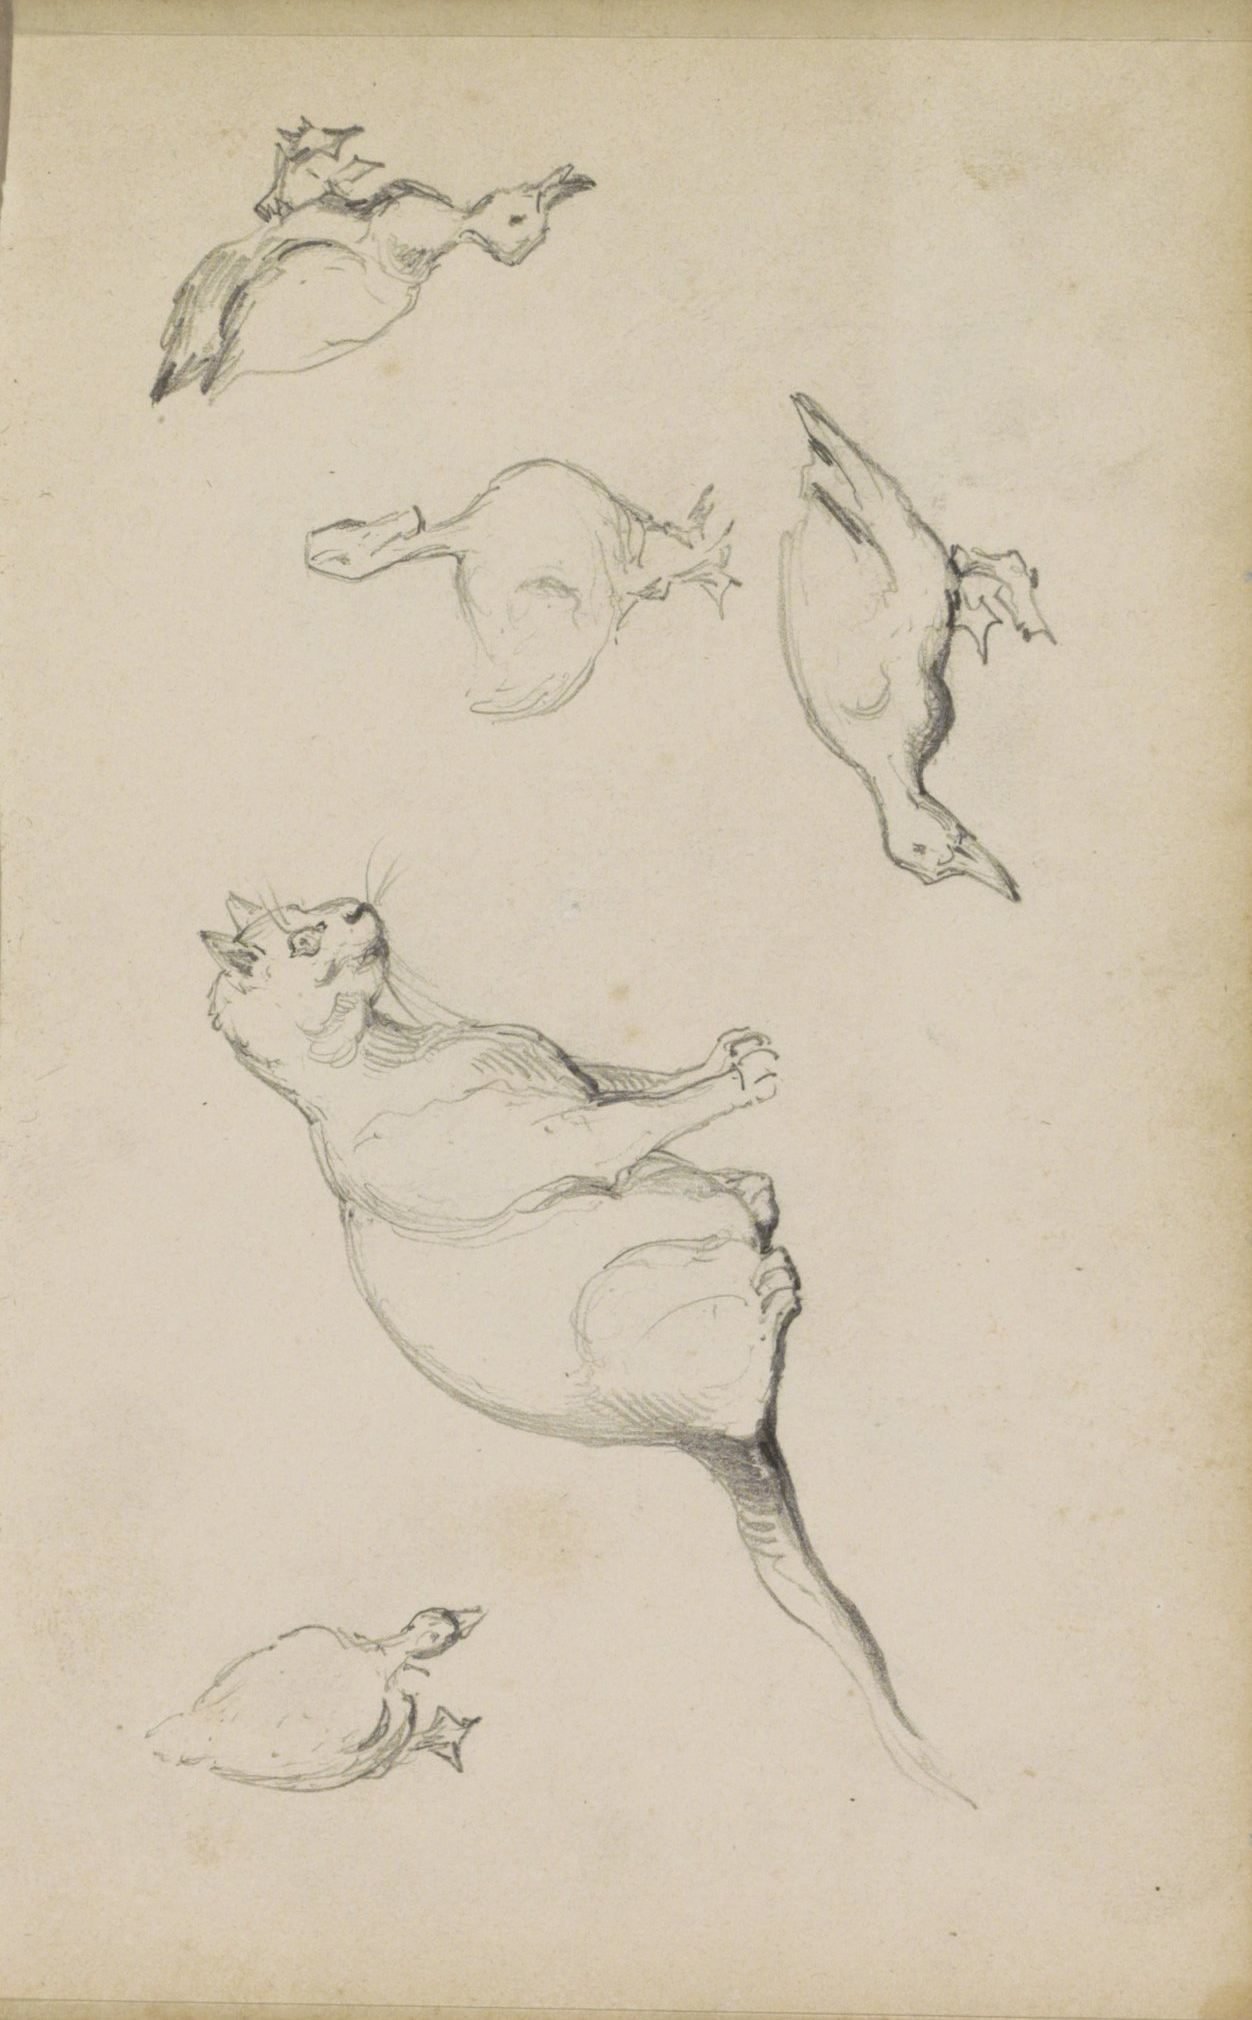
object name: sketchbook leaf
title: Kat en eenden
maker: johannes tavenraat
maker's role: draughtsman, painter, print maker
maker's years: 1809-1881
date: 1839-1872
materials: paper, pencil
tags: cat, water-birds: duck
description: Blad 40 recto uit een schetsboek met 73 bladen.